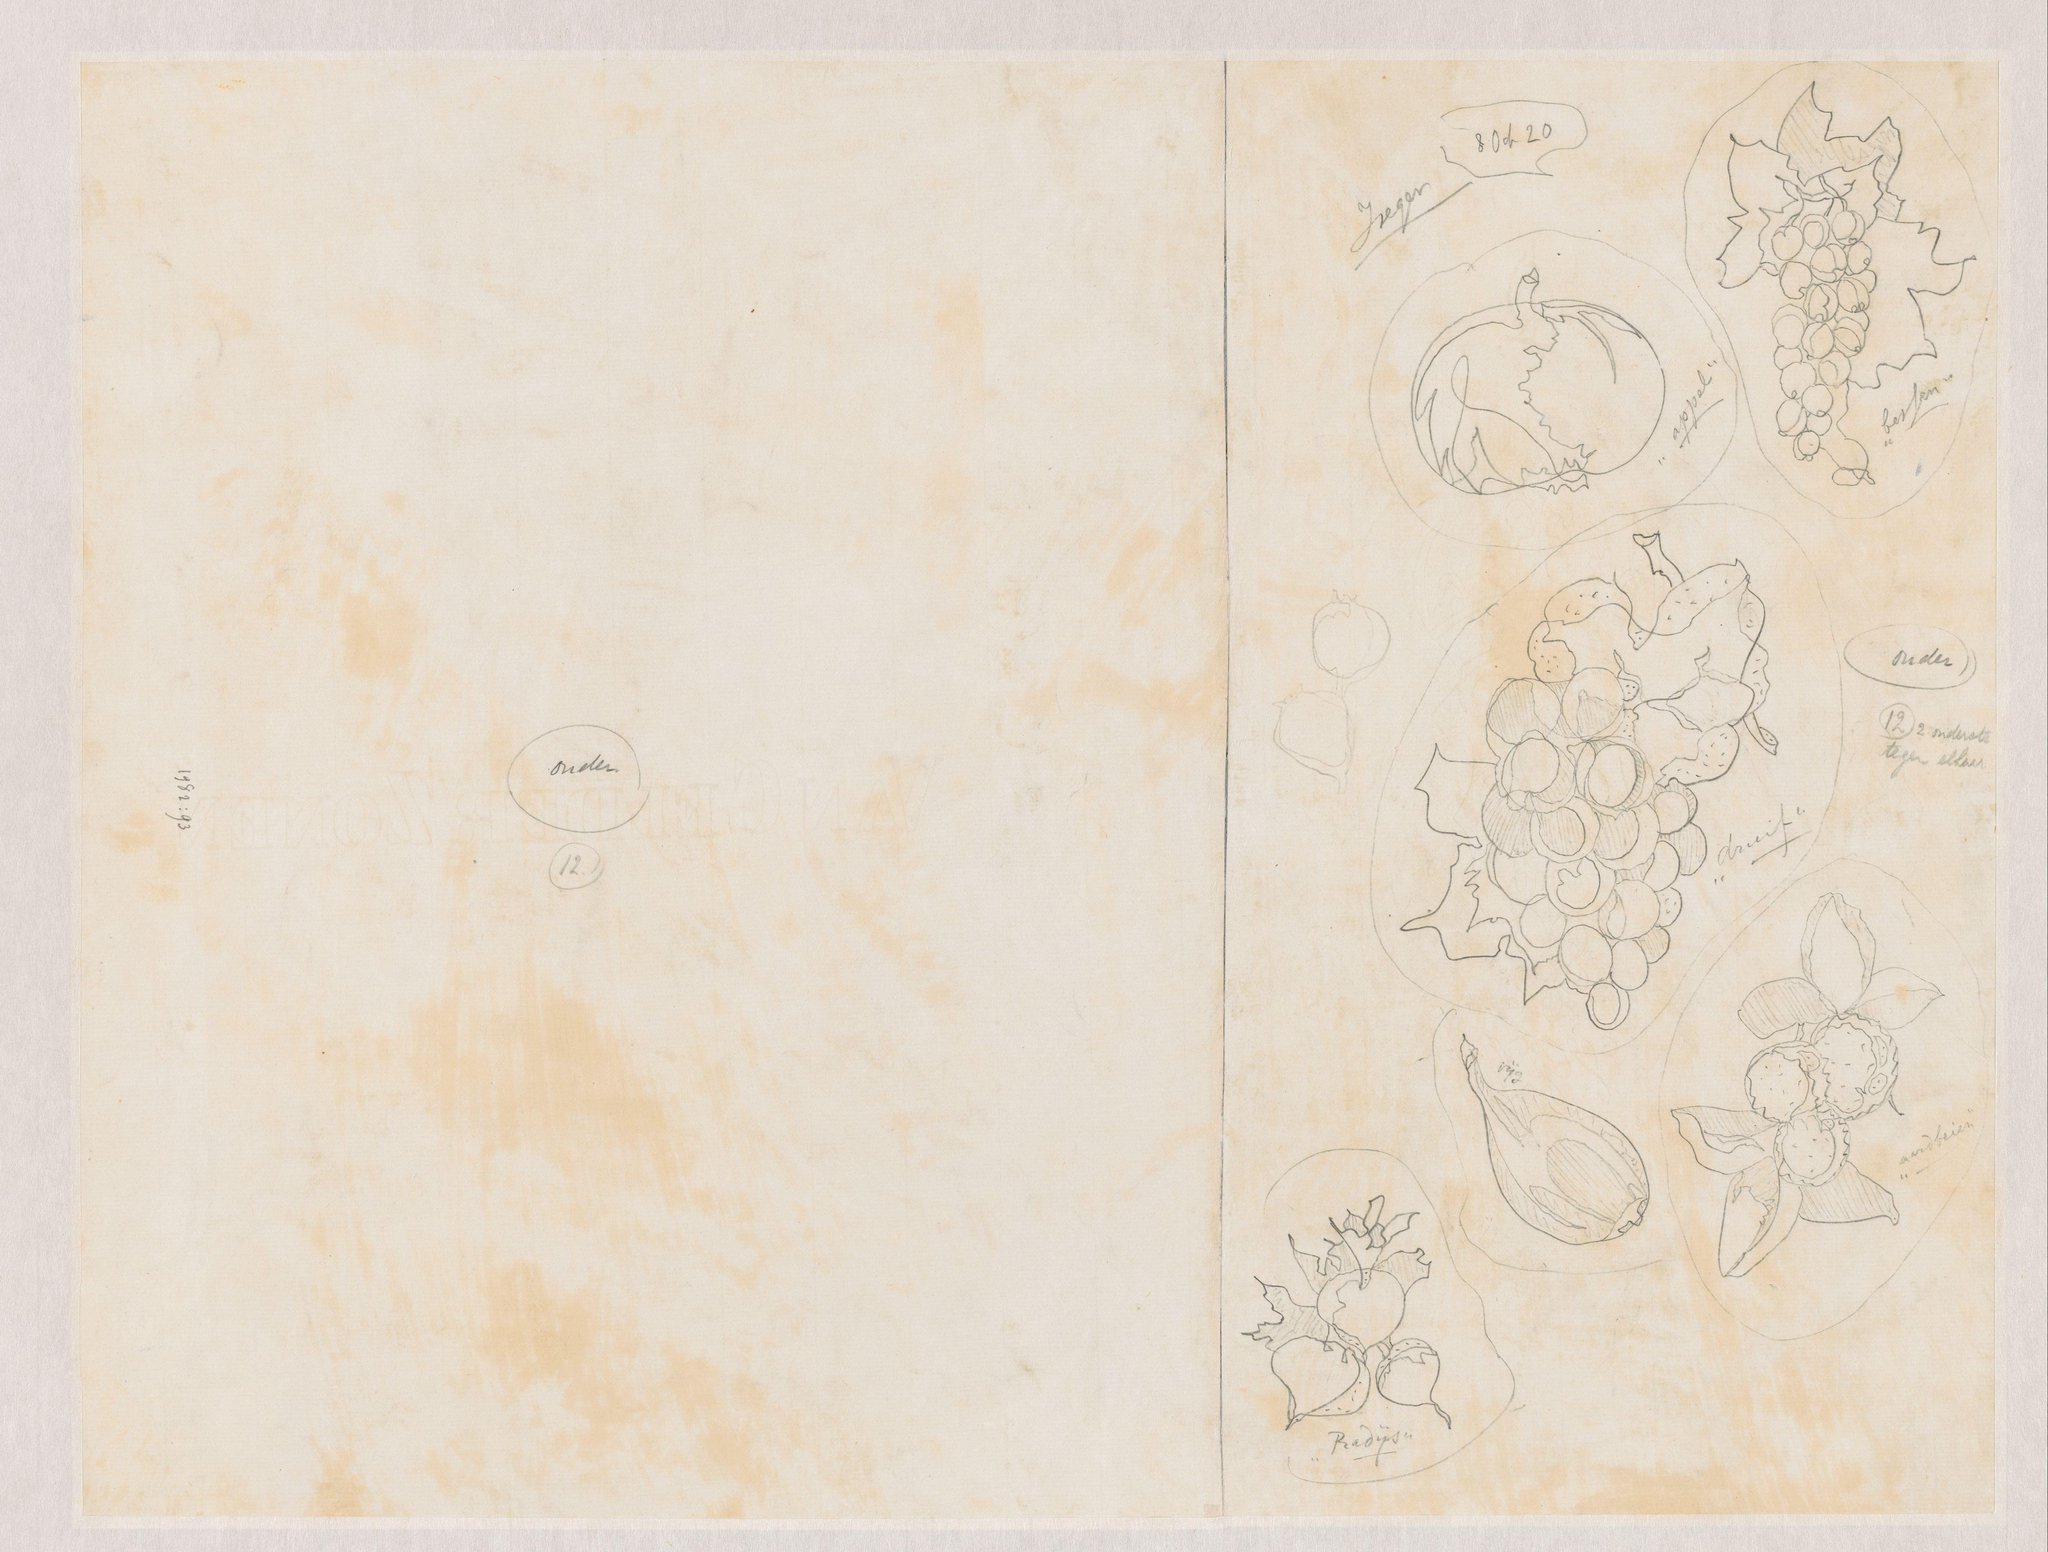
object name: design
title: Ontwerpen voor aardewerkdecoratie: appel, druif, bessen, vijg, radijs en aardbeien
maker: theo colenbrander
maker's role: draughtsman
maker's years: 1841-1930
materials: paper, pencil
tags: vegetables, fruits: strawberry, fruits: apple, fruits: fig, plants and herbs: radish, bunch of grapes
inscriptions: date: ‘begonnen 15 maart 18 en gereed 8 oct 18’